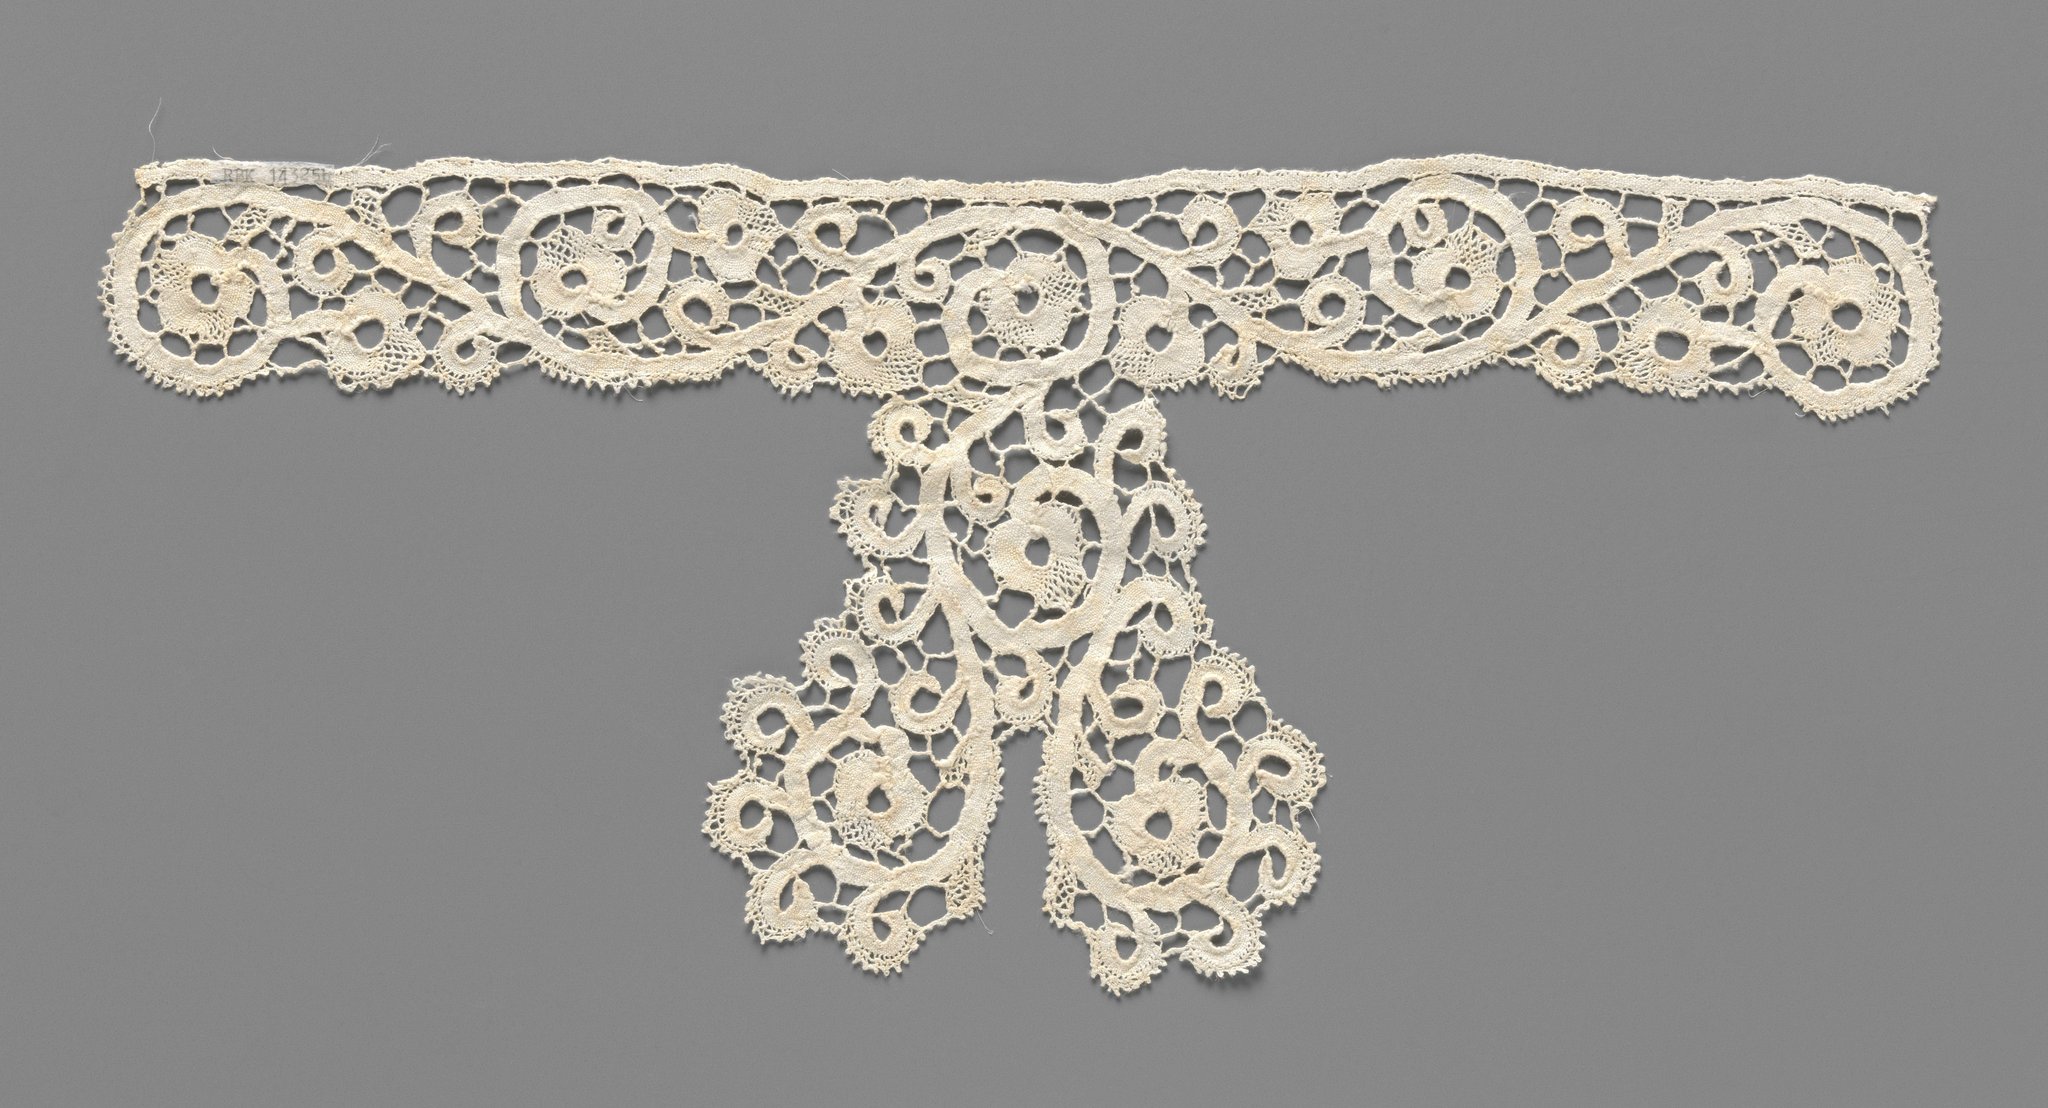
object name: collar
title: Kraag van kloskant met aangehecht jabot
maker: Anonymous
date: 1900-1924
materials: linen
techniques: lace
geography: belgium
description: Kraag met aangehecht jabot van naturelkleurige Venetiaanse kloskant. Strookvormig model waaronder een hartvormig jabot hangt. Het overwegend symmetrische patroon bestaat uit een golvende rank met vijf sterk omkrullende zijtakken met aan elk uiteinde een drie- of vijflobbige bloem. De hartvormige jabot wordt gevormd door drie van zulke omkrullende ranken met dito bloem aan elk uiteinde. Rondom het hart, aan de omkrullende ranken verschillende korte zijtakjes die allemaal dezelfde kant op krullen. De motieven zijn grotendeels gemaakt in linnenslag met hier en daar opengewerkte randjes. Voor enkele (bloem)blaadjes is een andere slag gebruikt. De motieven zijn met elkaar verbonden door vlechtjes. De bovenzijde van het geheel is recht afgewerkt. De omkrullende ranken en zijtakjes vormen een schulpenrand langs de overige randen.